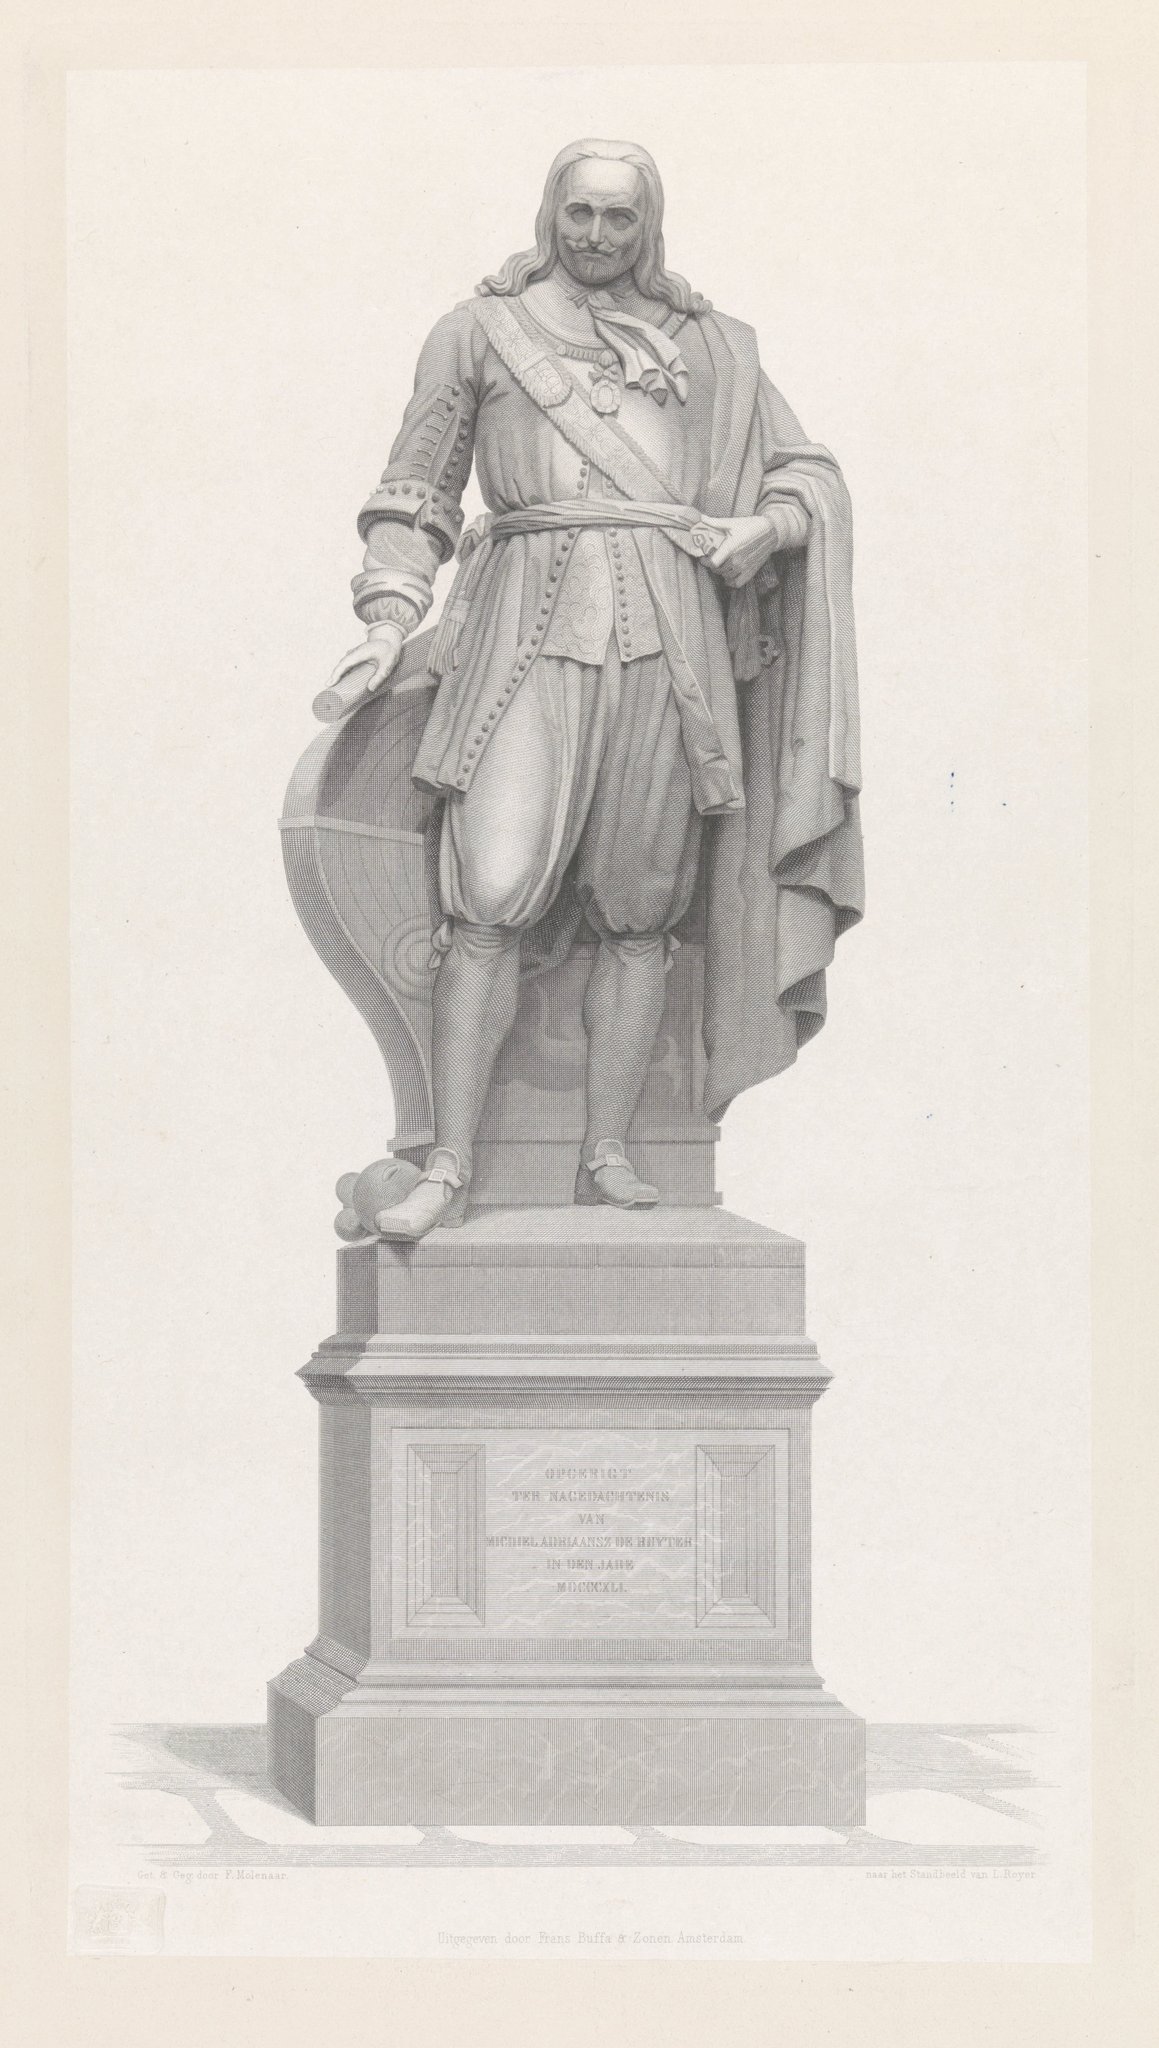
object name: print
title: Standbeeld van Michiel Adriaenszoon de Ruyter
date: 1841-1843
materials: paper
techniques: engraving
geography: amsterdam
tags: flushing, michiel adriaenszoon de ruyter, sculpture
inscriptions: collector's mark: Lugt 12, check stamp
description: Het standbeeld van Michiel Adriaenszoon de Ruyter, zoals het werd opgericht te Vlissingen in 1841.